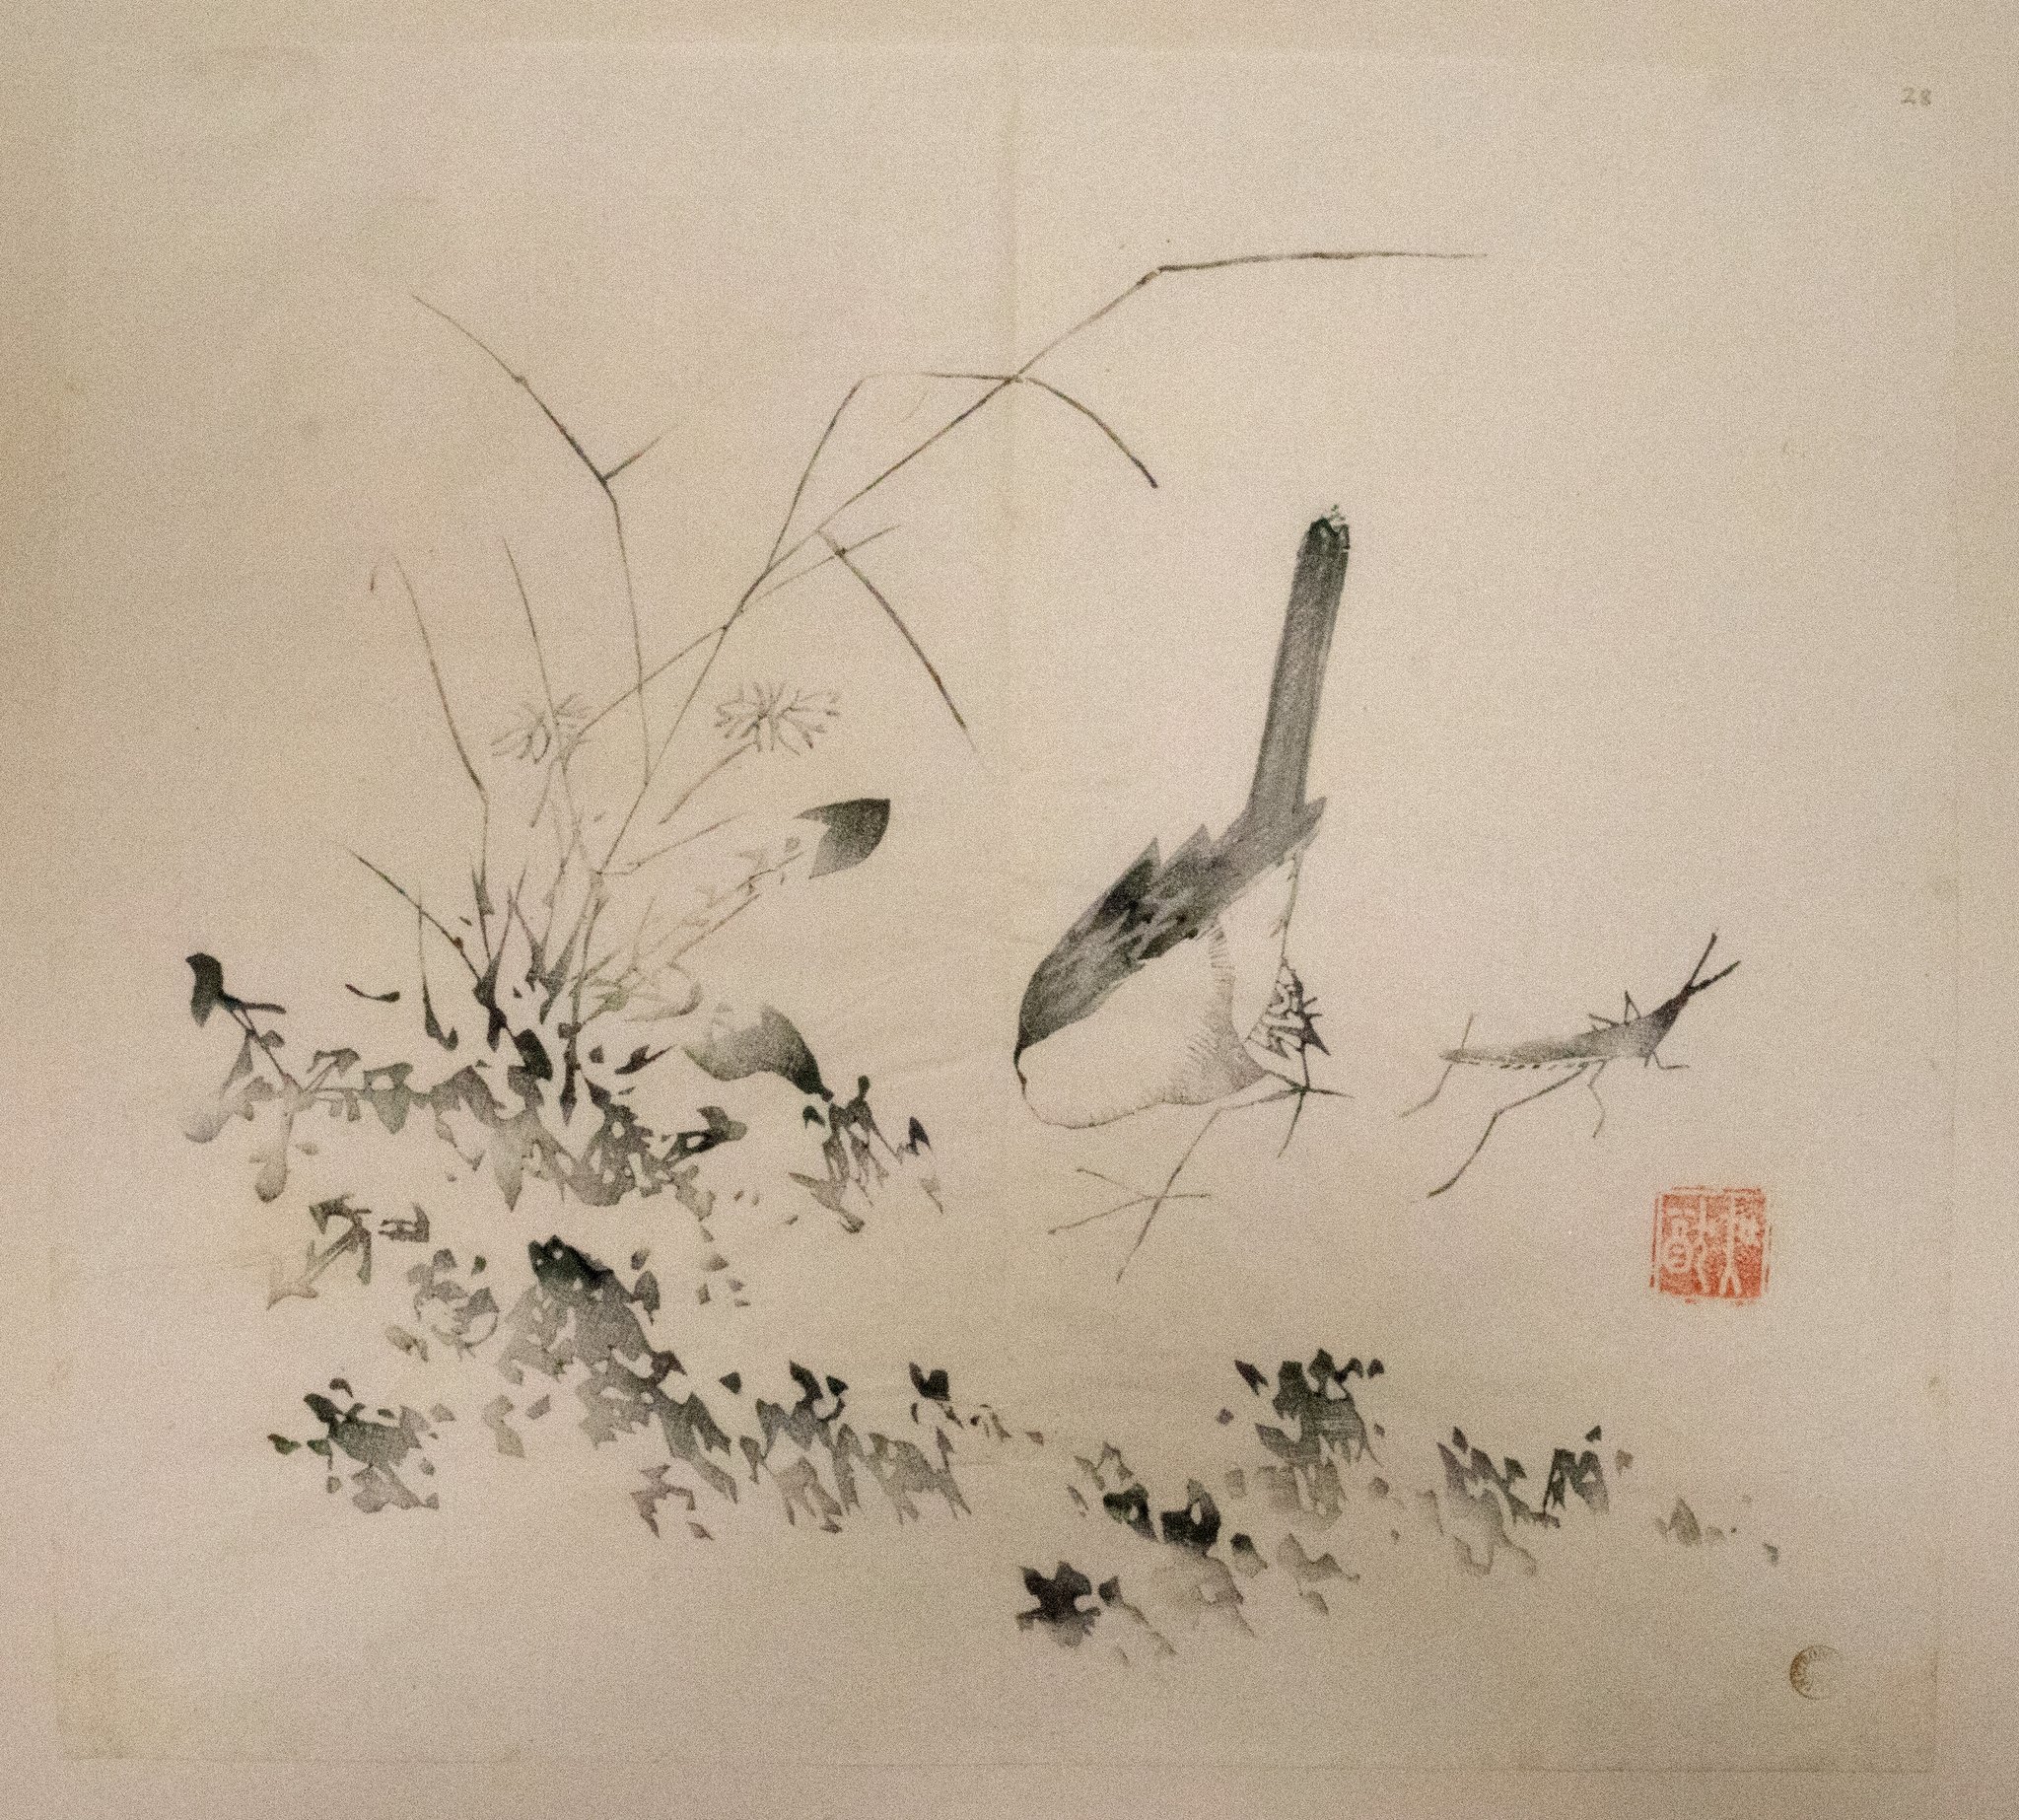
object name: print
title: Page from Shi Zhu Zhai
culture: chinese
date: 1736-1795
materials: ink, paper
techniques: polychrome, woodblock print